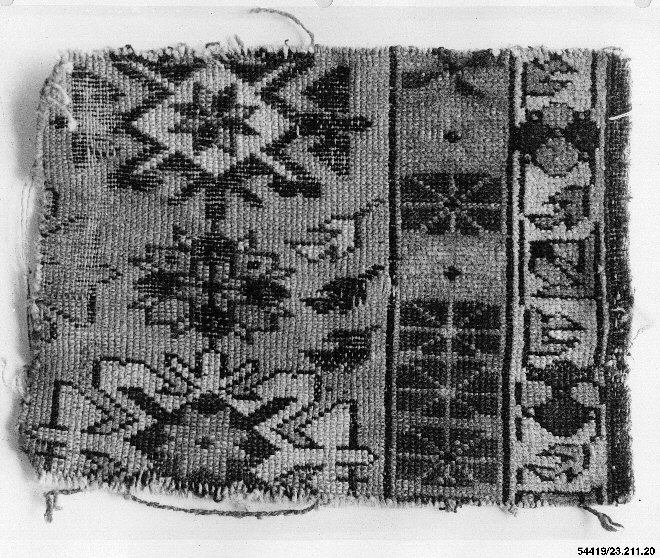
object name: carpet fragment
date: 1801-1833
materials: wool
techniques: pile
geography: azerbaijan